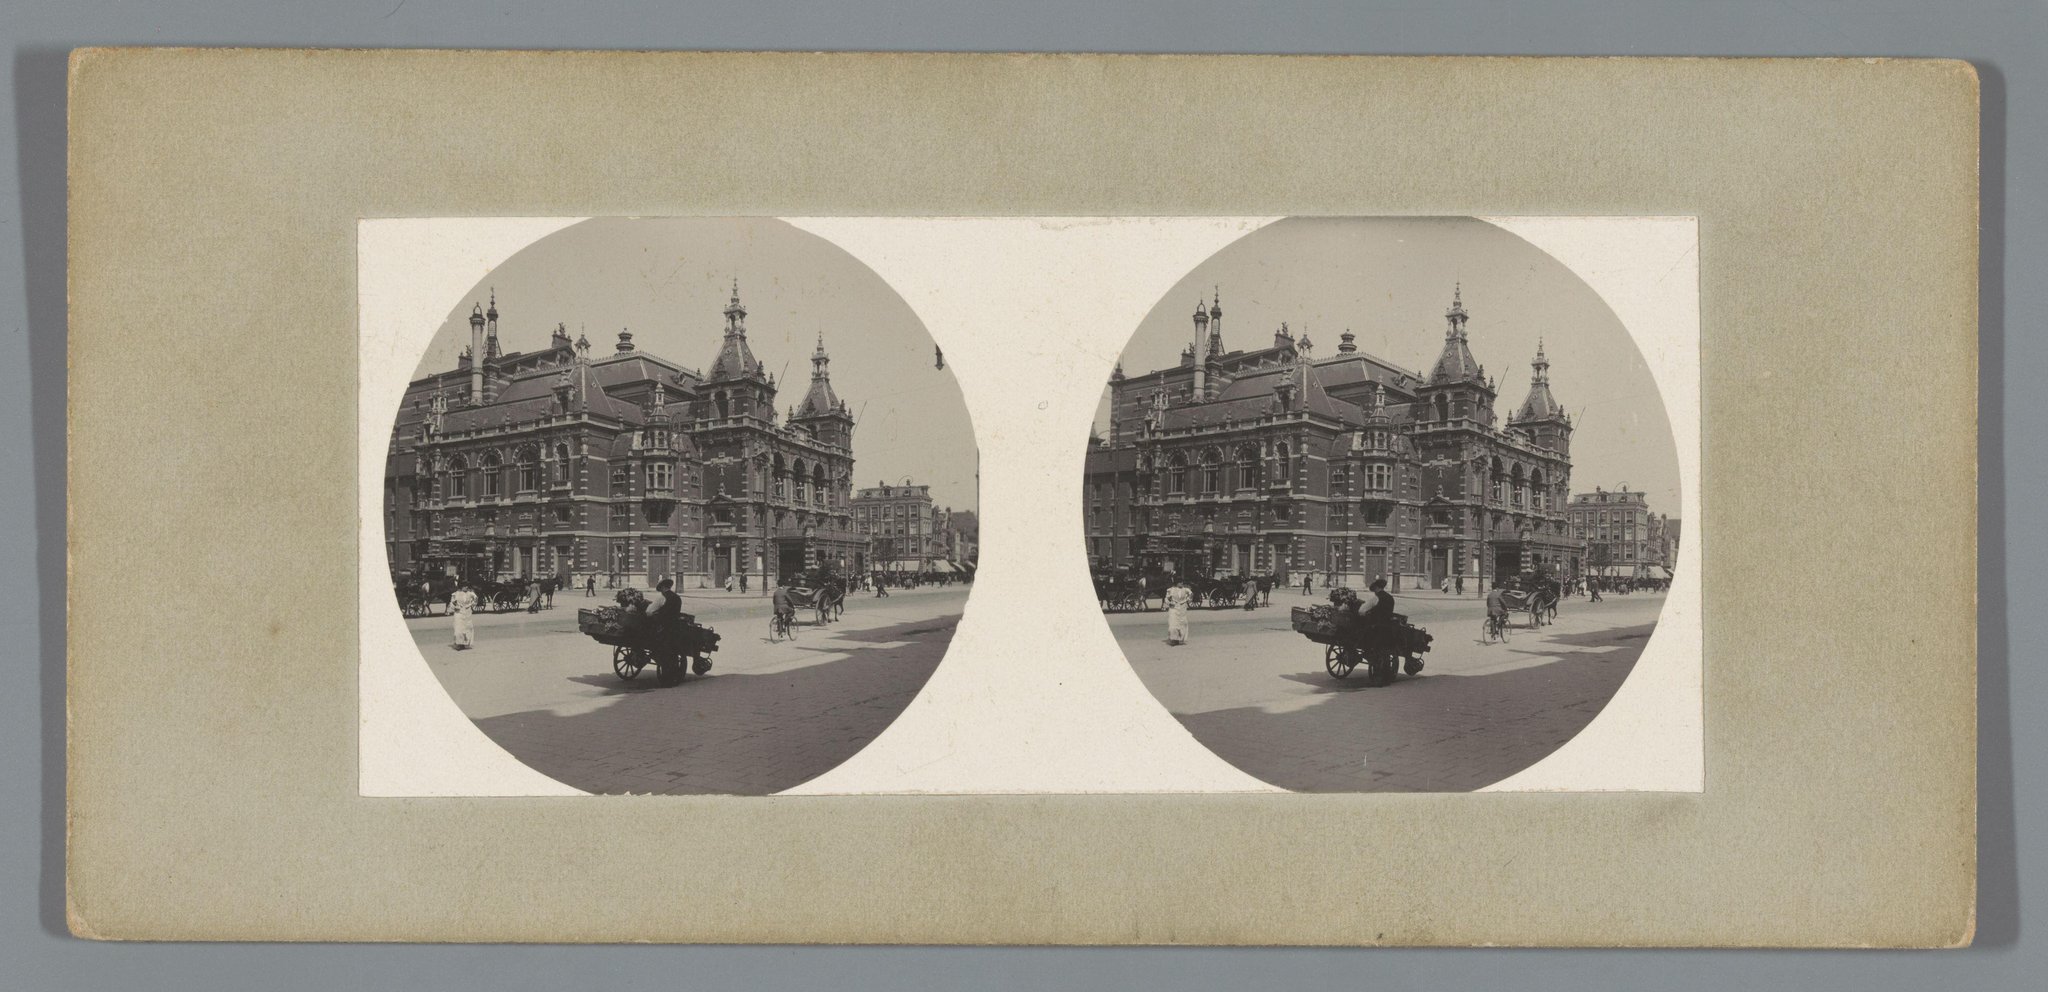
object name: stereograph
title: Stadsschouwburg aan het Leidseplein, Amsterdam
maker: Anonymous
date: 1894-1910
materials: paper, cardboard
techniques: gelatin silver print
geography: amsterdam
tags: theatre (building)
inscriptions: inscription: ‘Stadsschouwburg/ Amsterdam’